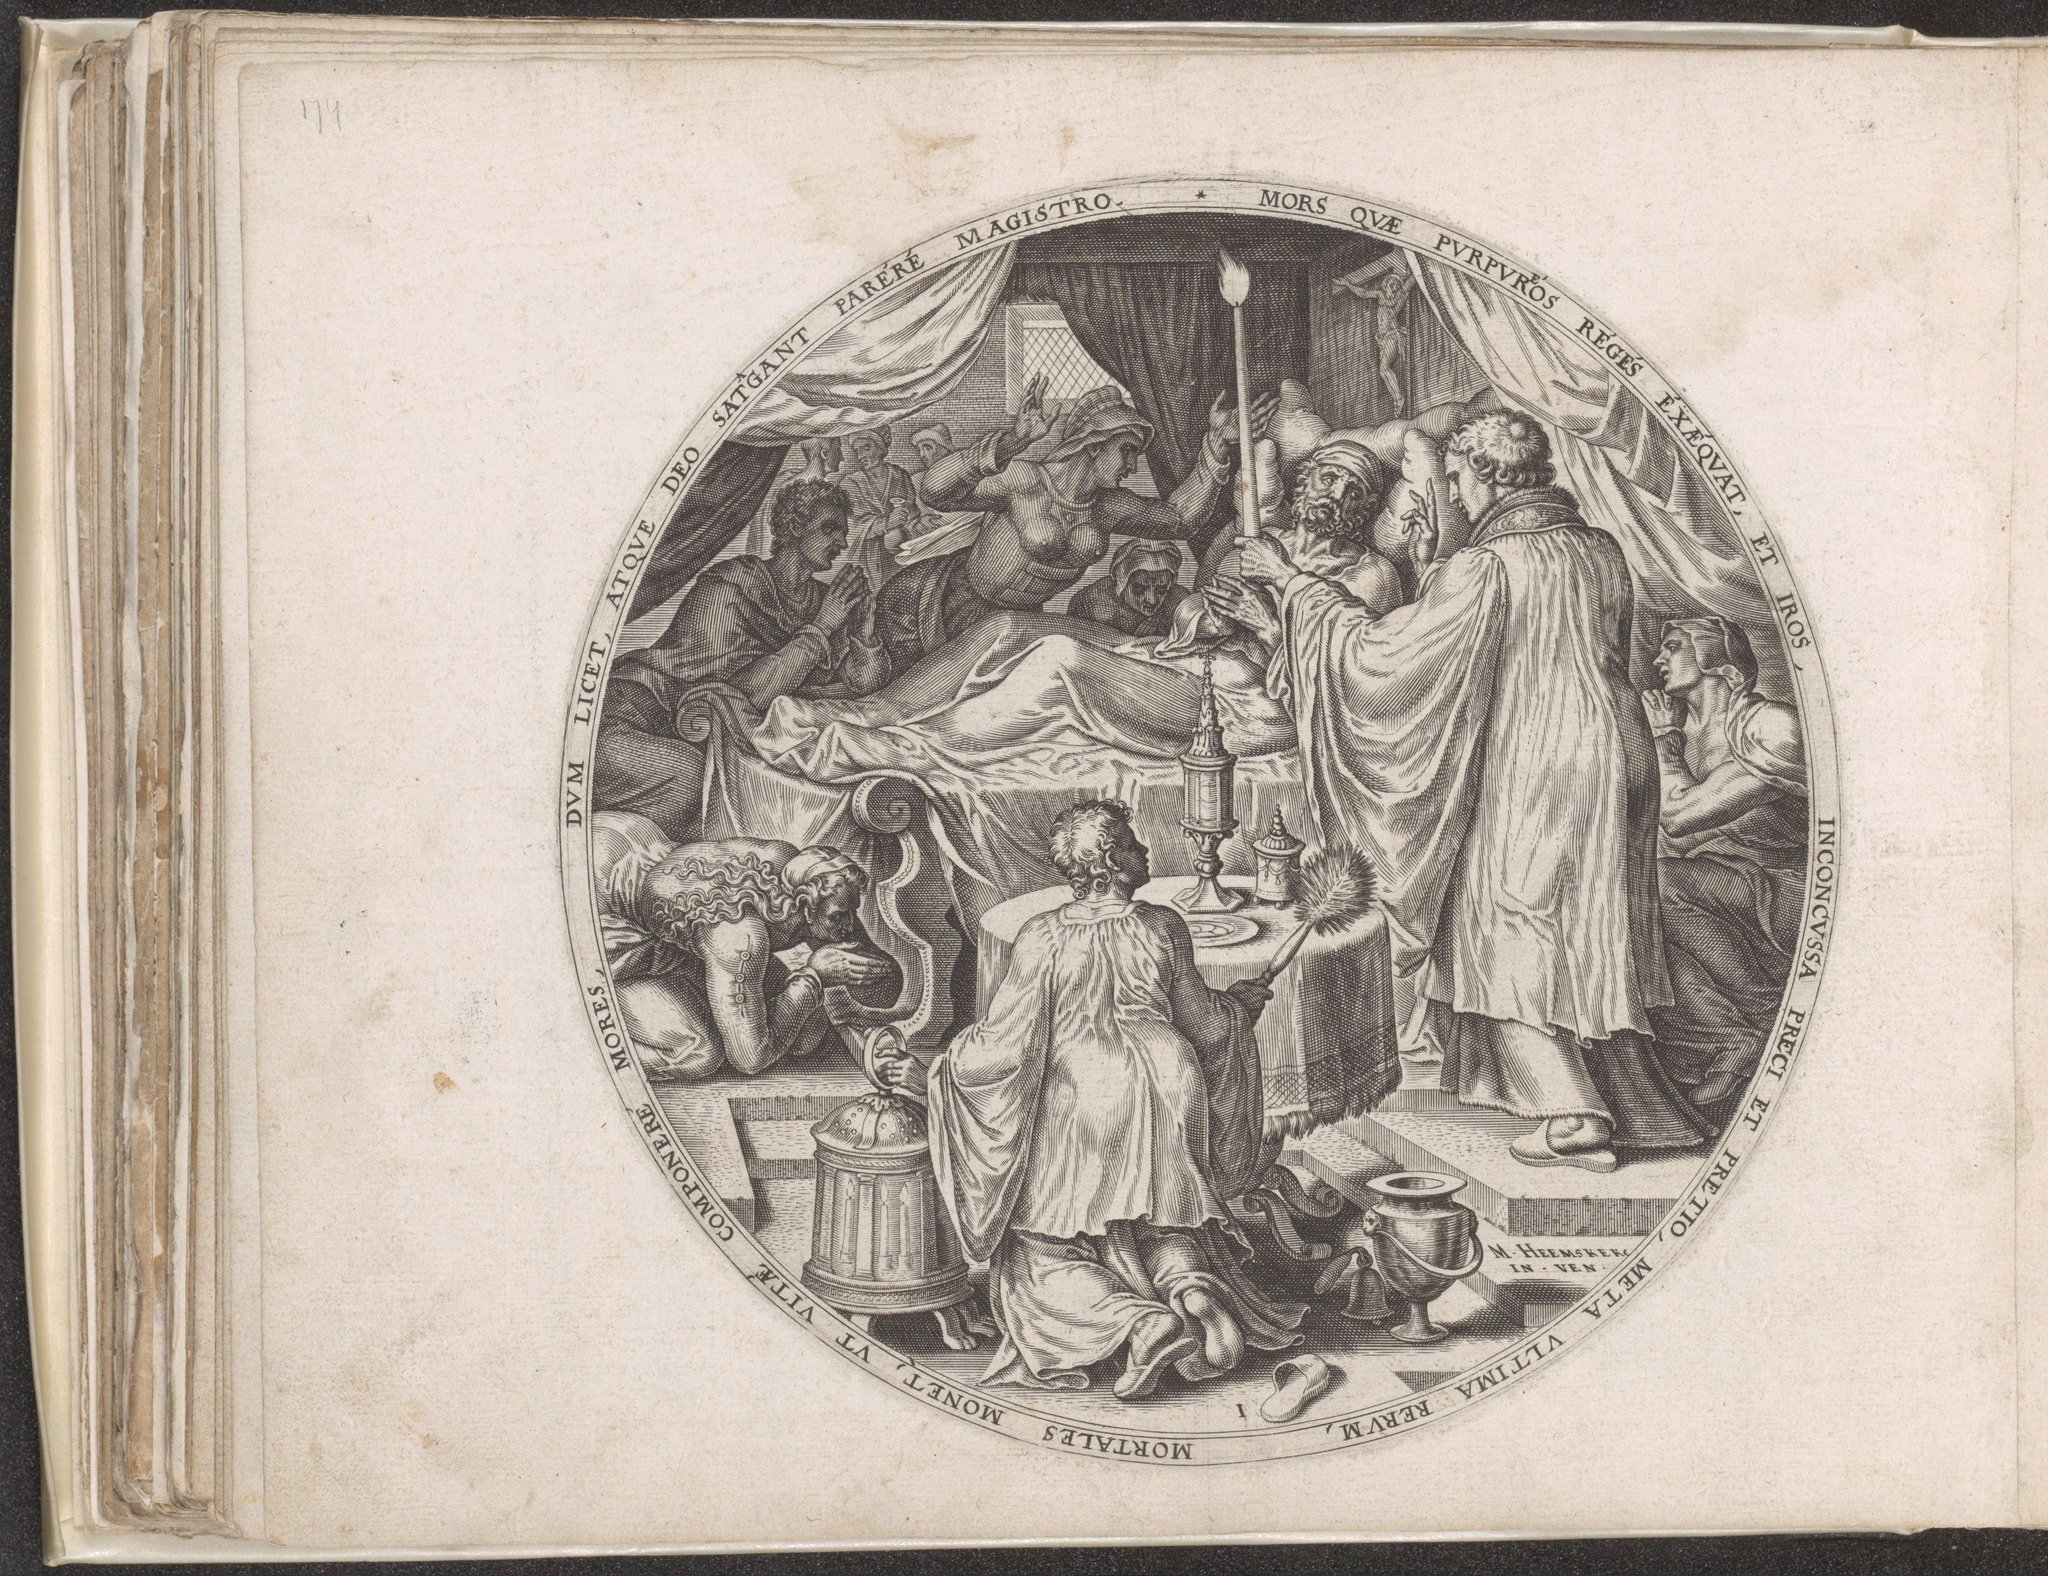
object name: print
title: Stervensuur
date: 1569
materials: paper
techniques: engraving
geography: haarlem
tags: deathbed, last communion, administering of the holy viaticum, priest at the bed of a dying person ~ extreme unction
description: Een man ligt op zijn sterfbed. Een geestelijke staat bij hem, met een kaars in de hand, terwijl hij met de andere hand een zegenend gebaar maakt. Op een tafel staat het gerei voor de bediening van de laatste communie klaar. Rond het bed familieleden, onder wie een wanhopige vrouw die haar handen ten hemel heft en aan het voeteneinde een geknielde biddende vrouw. Rond de voorstelling een randtekst in het Latijn. Deze prent maakt deel uit van een album.